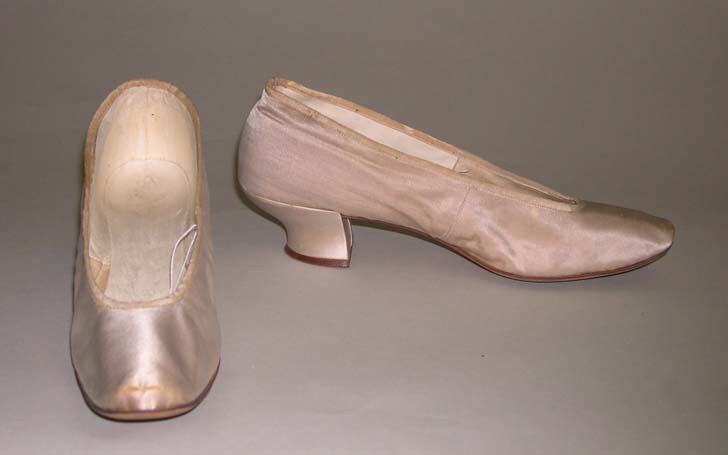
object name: wedding slipper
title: Wedding slippers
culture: american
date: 1883